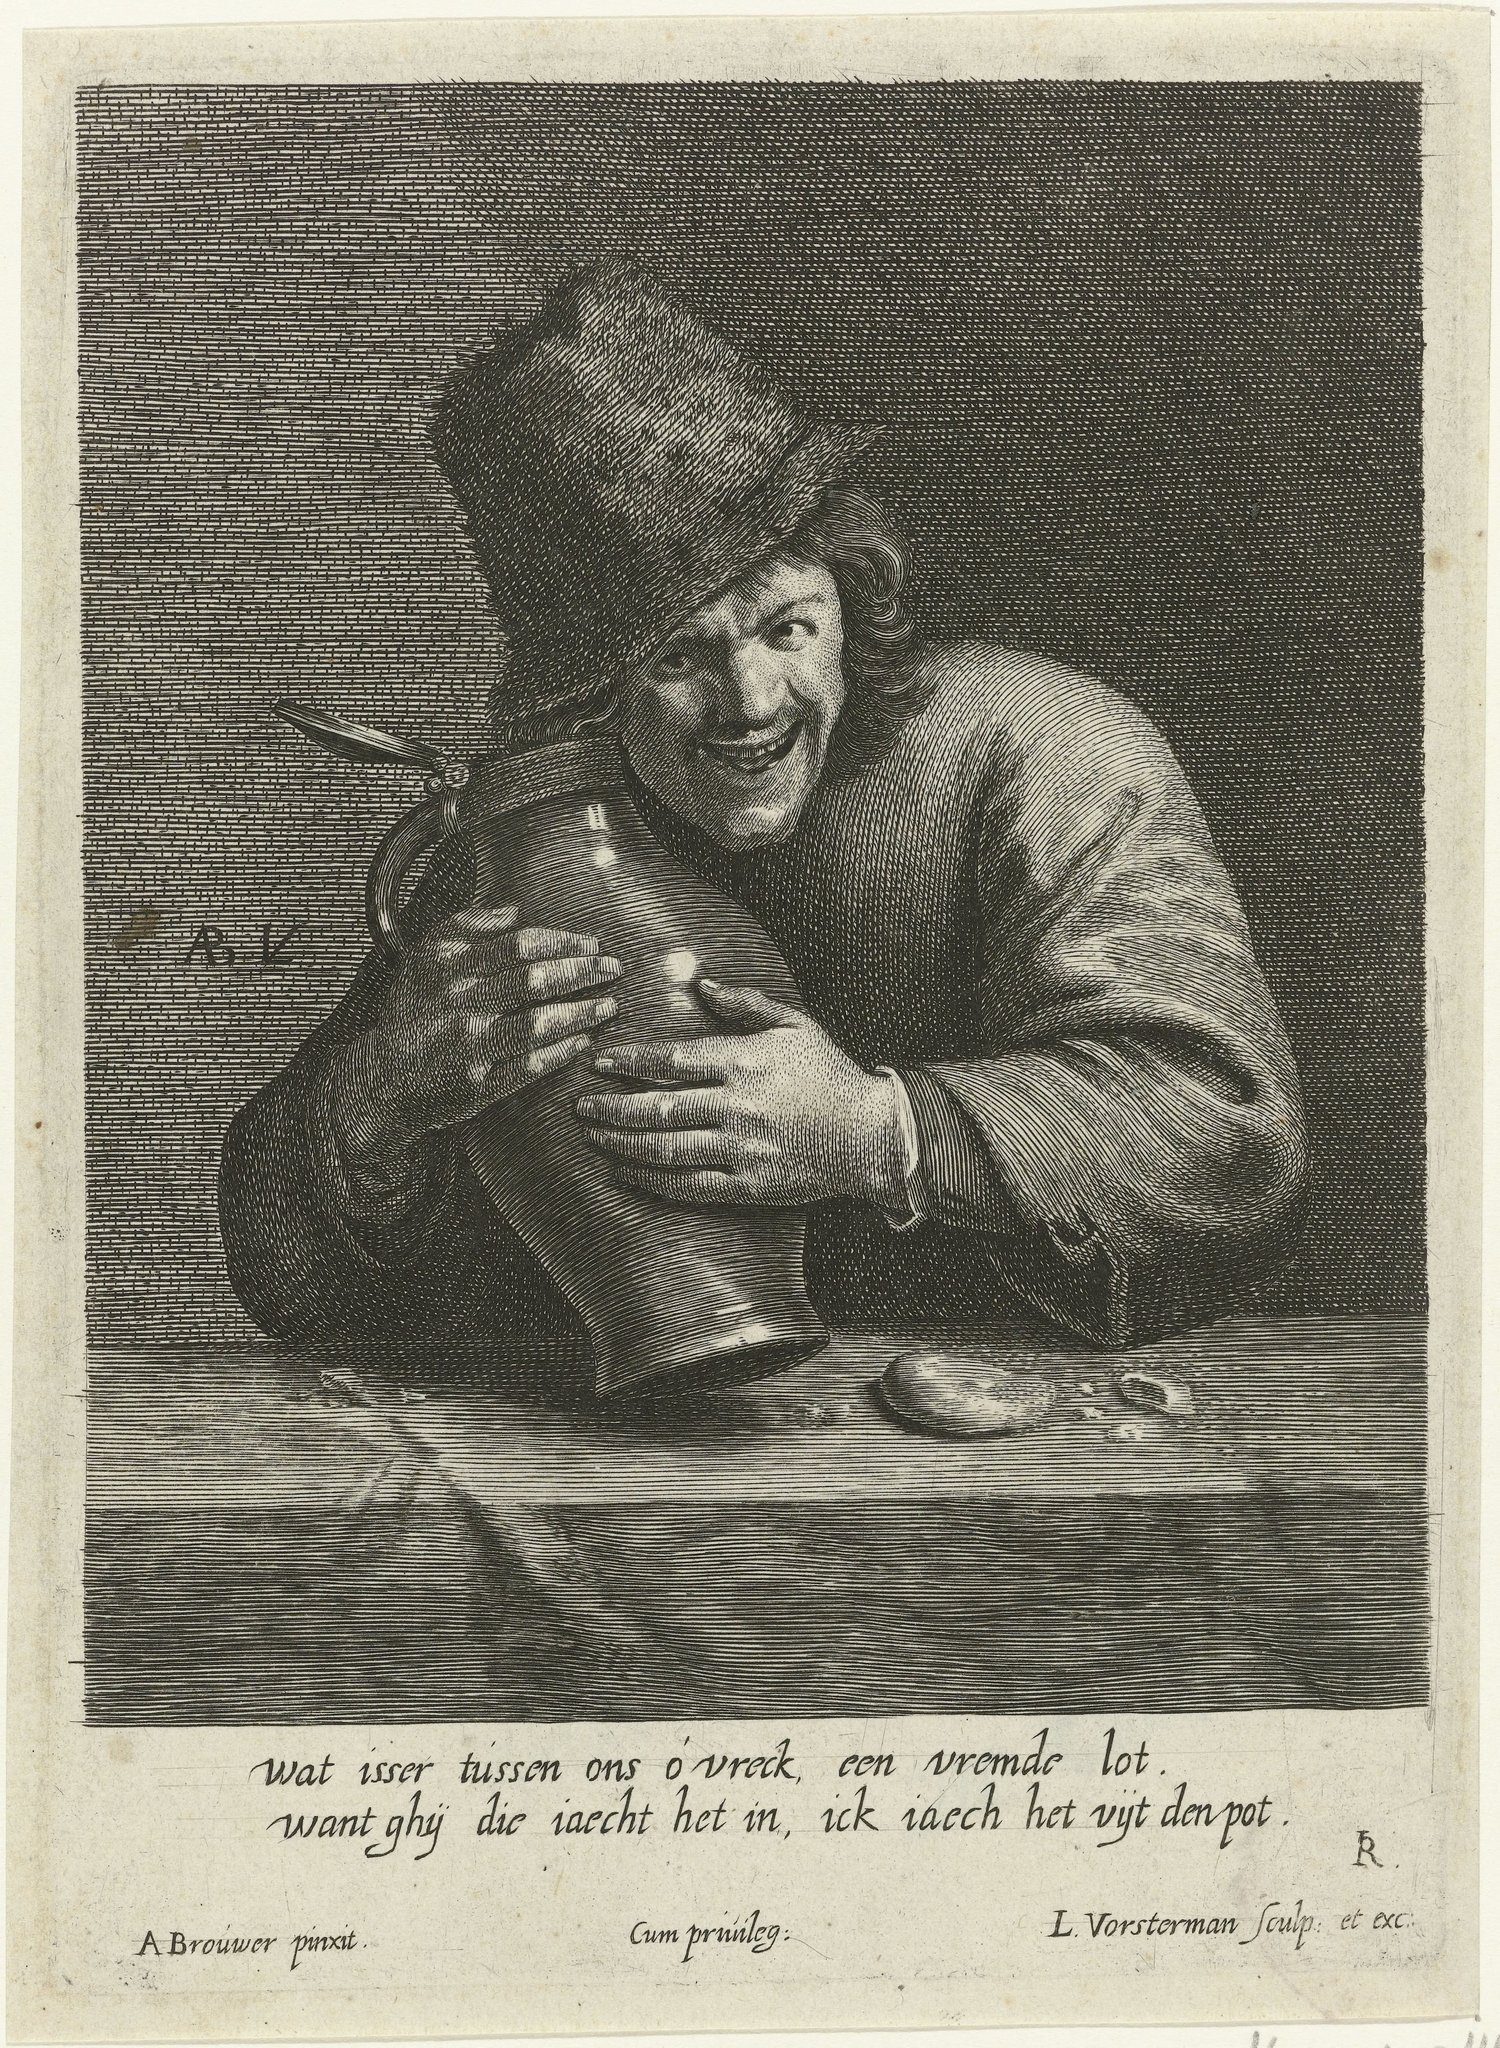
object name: print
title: Onmatigheid (Gula)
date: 1619-1675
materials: paper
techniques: engraving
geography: antwerp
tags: purse, money-bag, covetousness; 'avaritia' (ripa) ~ personification of one of the seven deadly sins, coin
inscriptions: collector's mark: Lugt 240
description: Een man houdt een kruik vast. Voor hem op de tafel ligt brood.